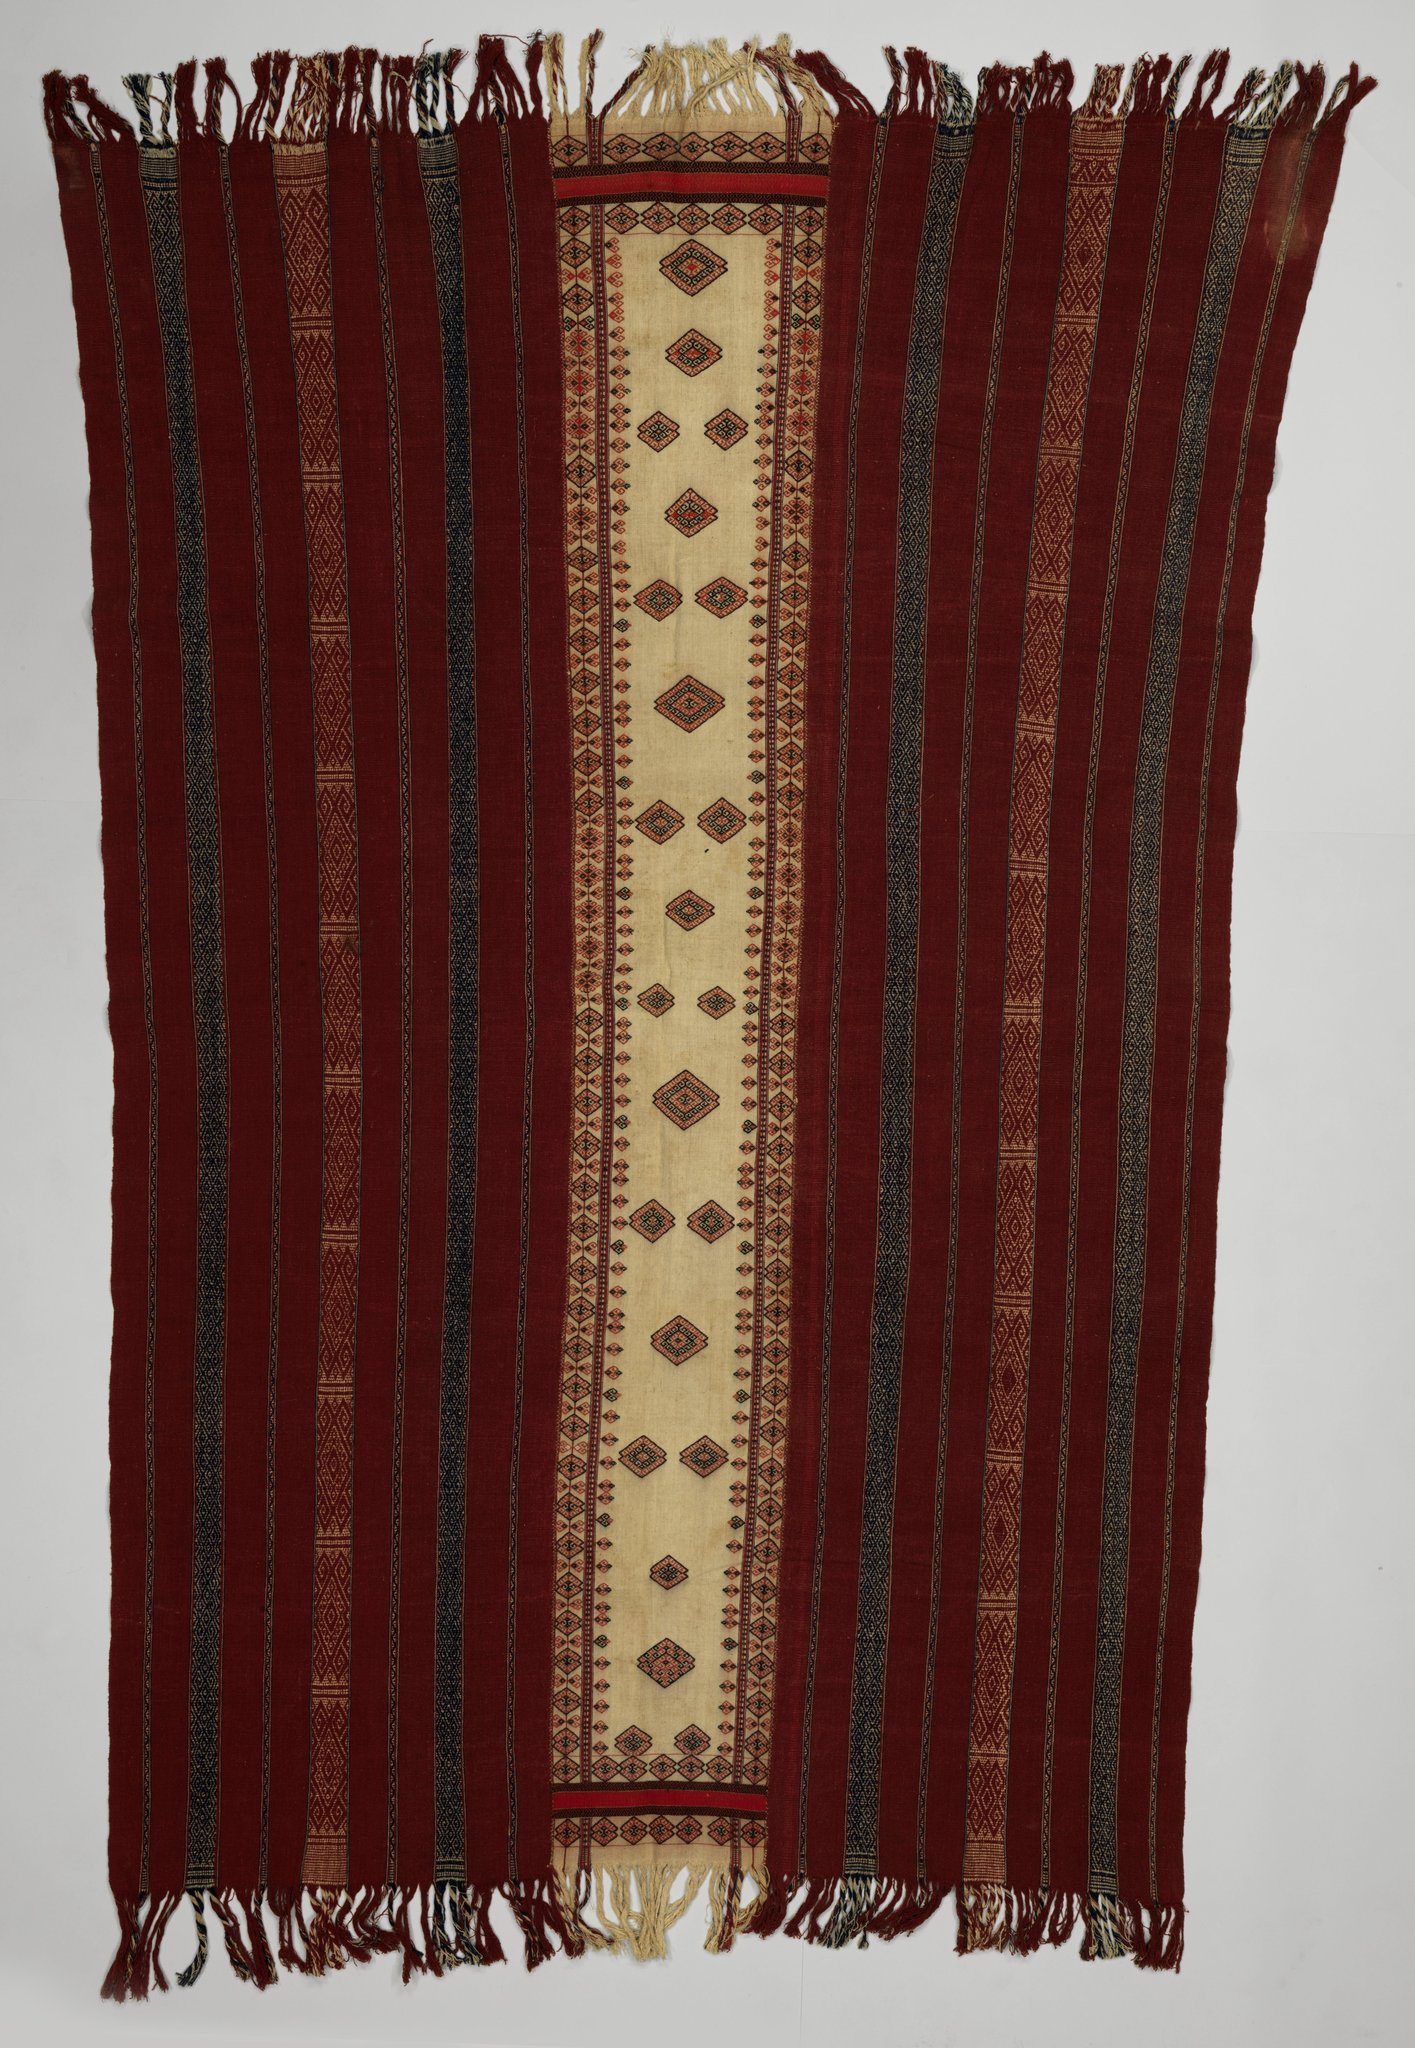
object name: omslagdoek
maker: Anonymous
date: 1900-1949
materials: cotton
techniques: weave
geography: timor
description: Omslagdoek met geometrische motieven op witte middenbaan.